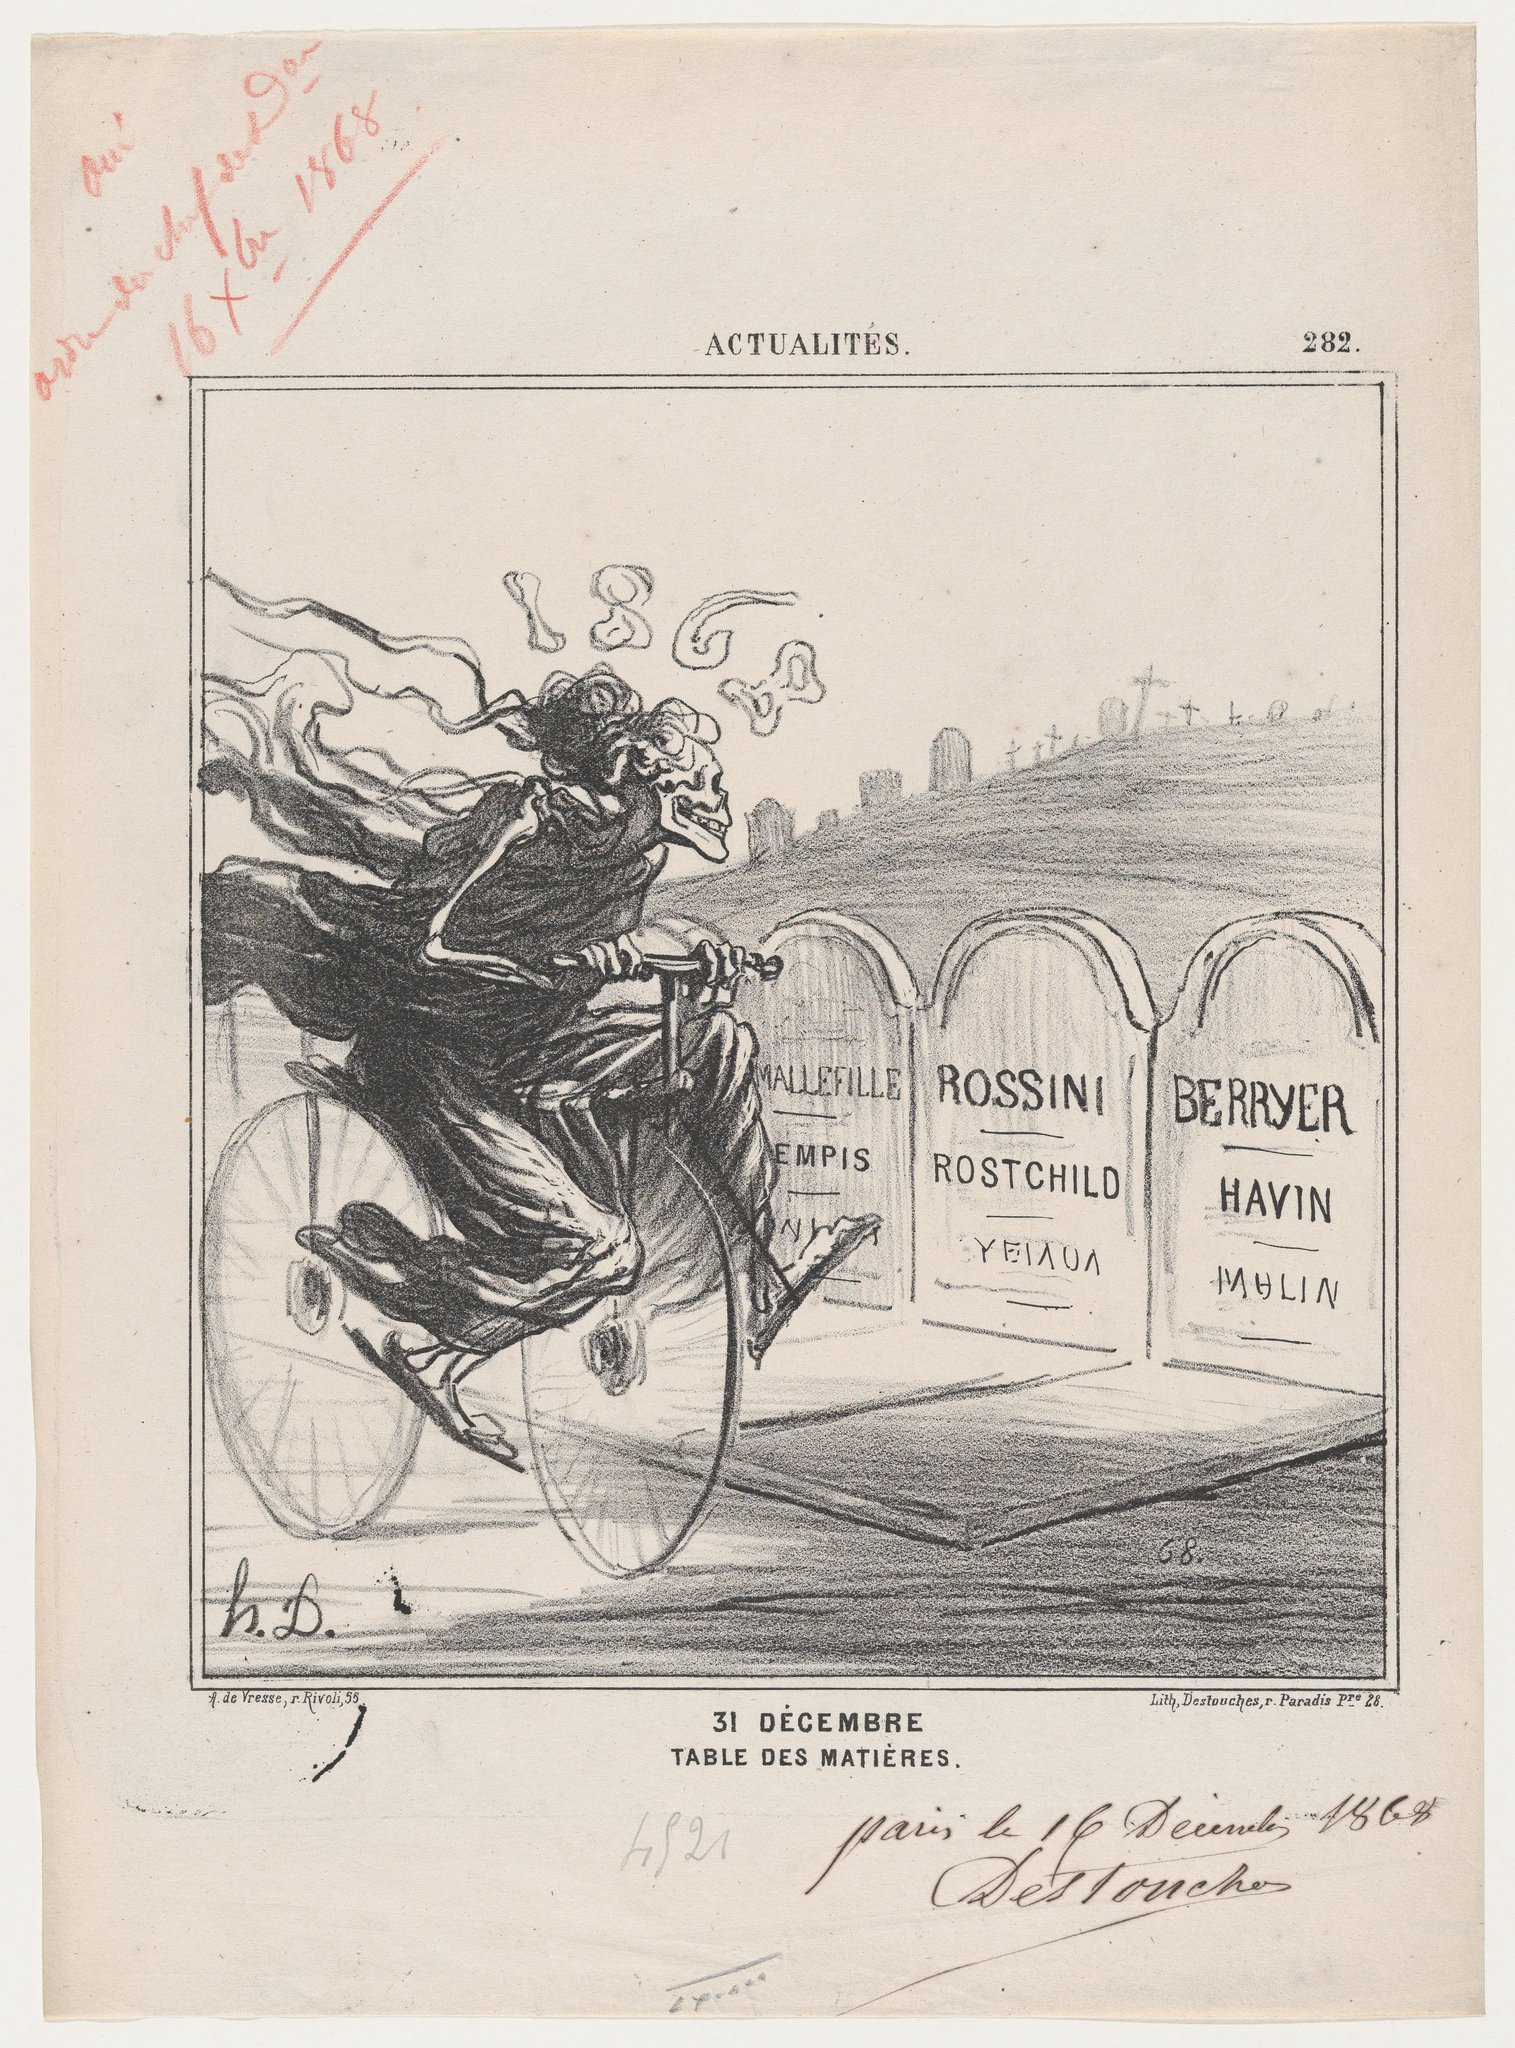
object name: print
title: December 31st, Table of contents, from 'News of the day,' published in Le Charivari, December 31, 1868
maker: honoré daumier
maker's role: artist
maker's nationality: french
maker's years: 1808-1879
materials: ink, paper, pencil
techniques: lithograph, pen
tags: satire,skeletons,bicycles